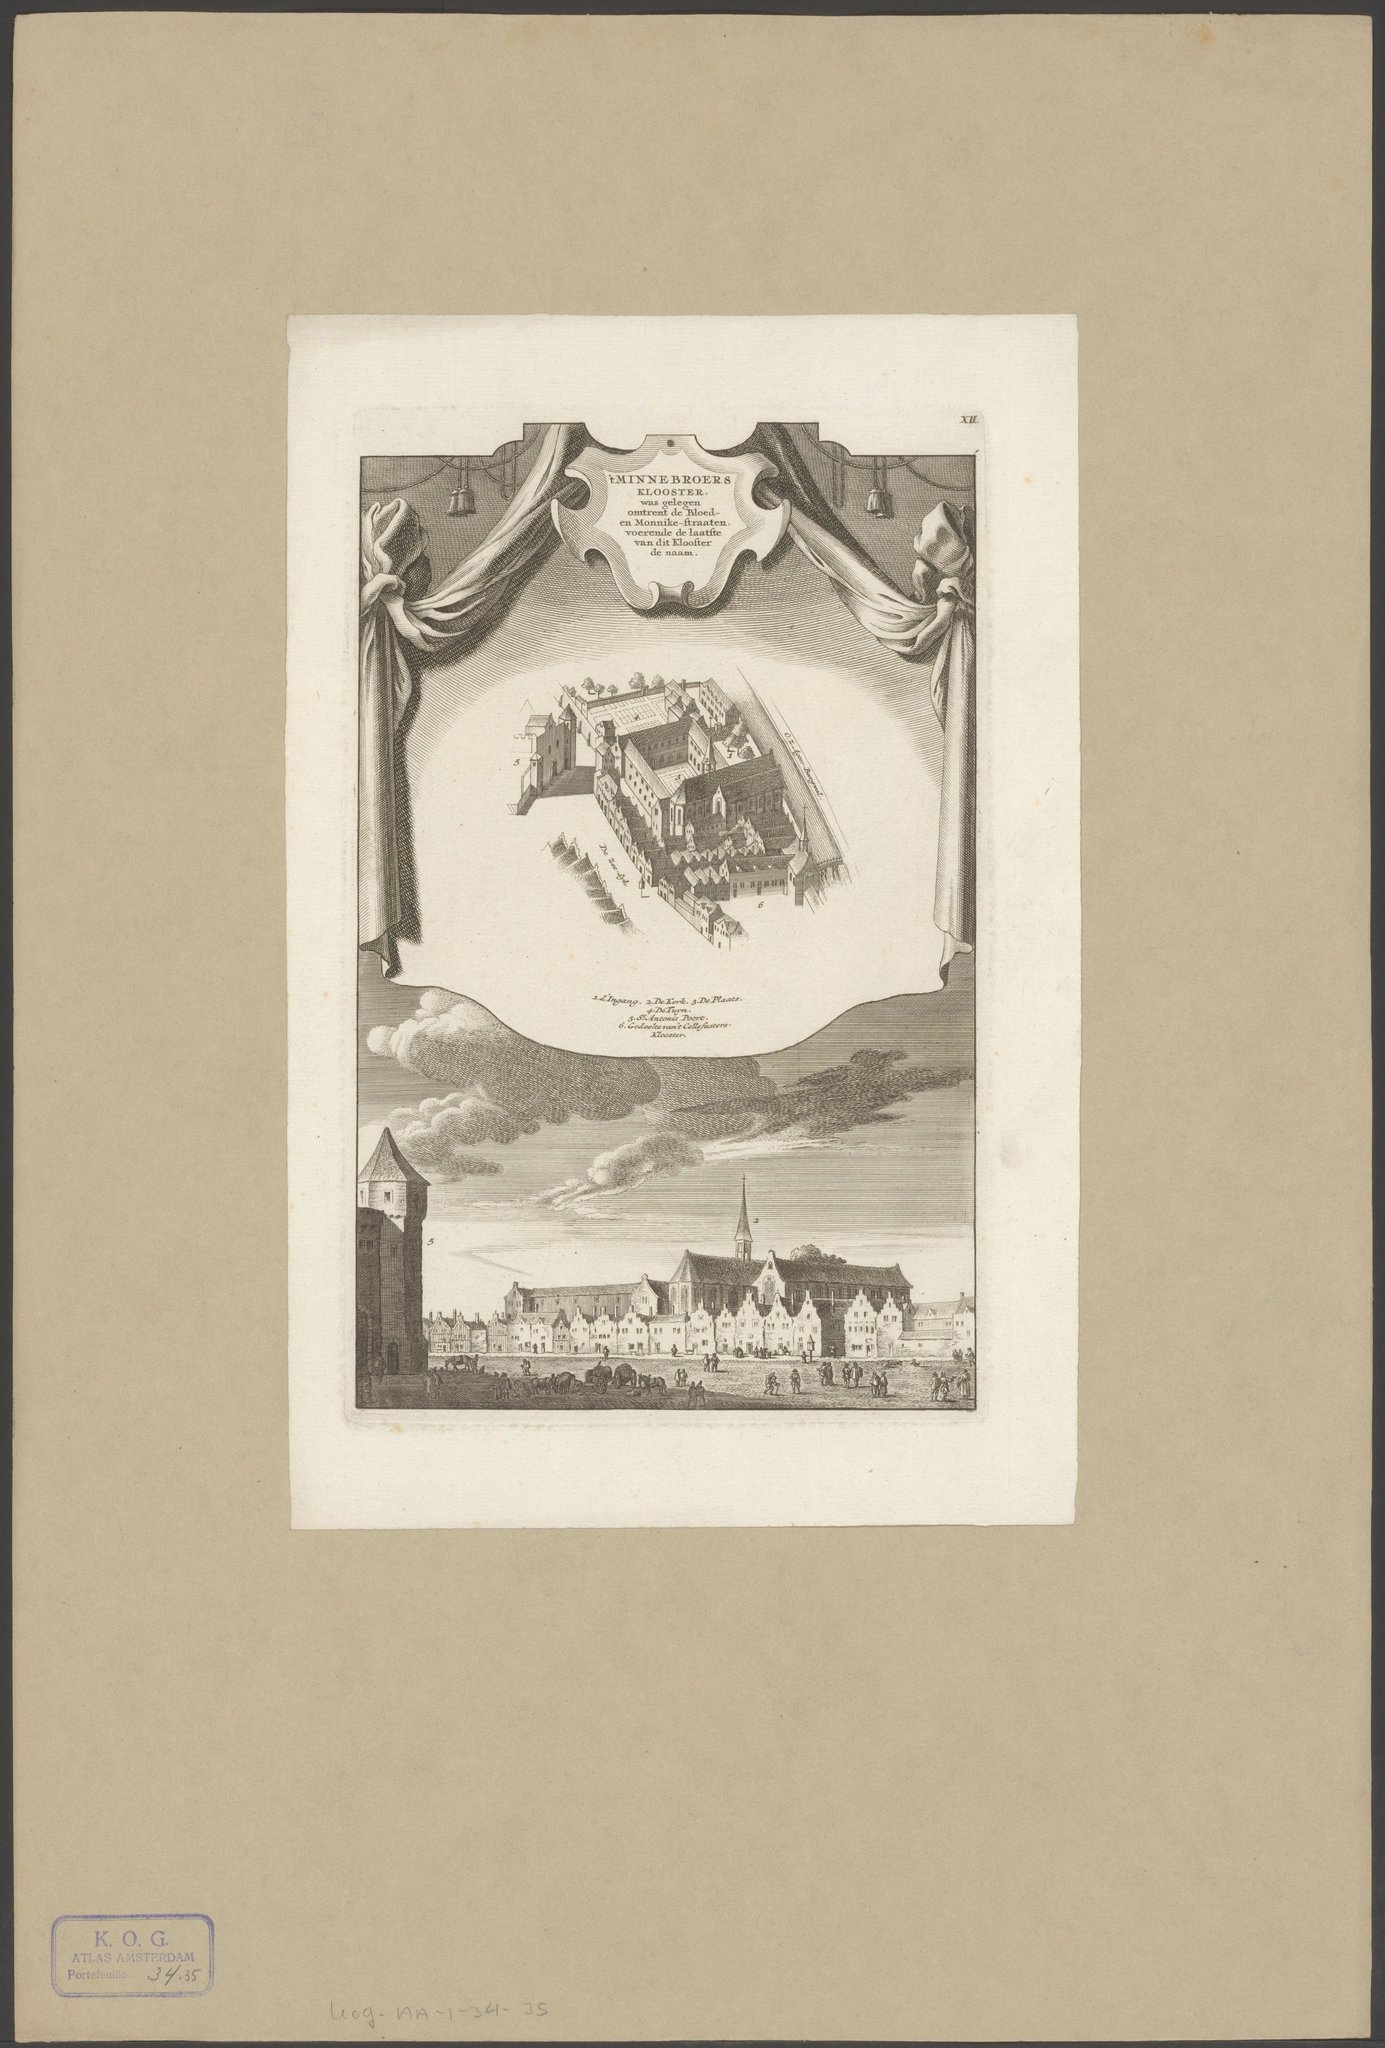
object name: print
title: Gezichten op het Minderbroedersklooster te Amsterdam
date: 1760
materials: paper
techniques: engraving, etching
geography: northern netherlands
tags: abbey, monastery, convent ~ roman catholic church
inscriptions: collector's mark: Lugt 1641b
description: Prent mogelijk uit: Wagenaar, Jan. Amsterdam, in zyne opkomst, aanwas, geschiedenissen (…). Amsterdam: Isaak Tirion, 1760, dl. 1. Dat de prent de situatie rond 1544 weergeeft, gaat terug op het feit dat voor het maken van deze en andere prenten van kloosters en kerken van voor de Alteratie (1578) is uitgegaan van de plattegrond van Cornelis Anthonisz. uit 1544, zie RP-P-OB-70.399 en RP-P-AO-20-15.